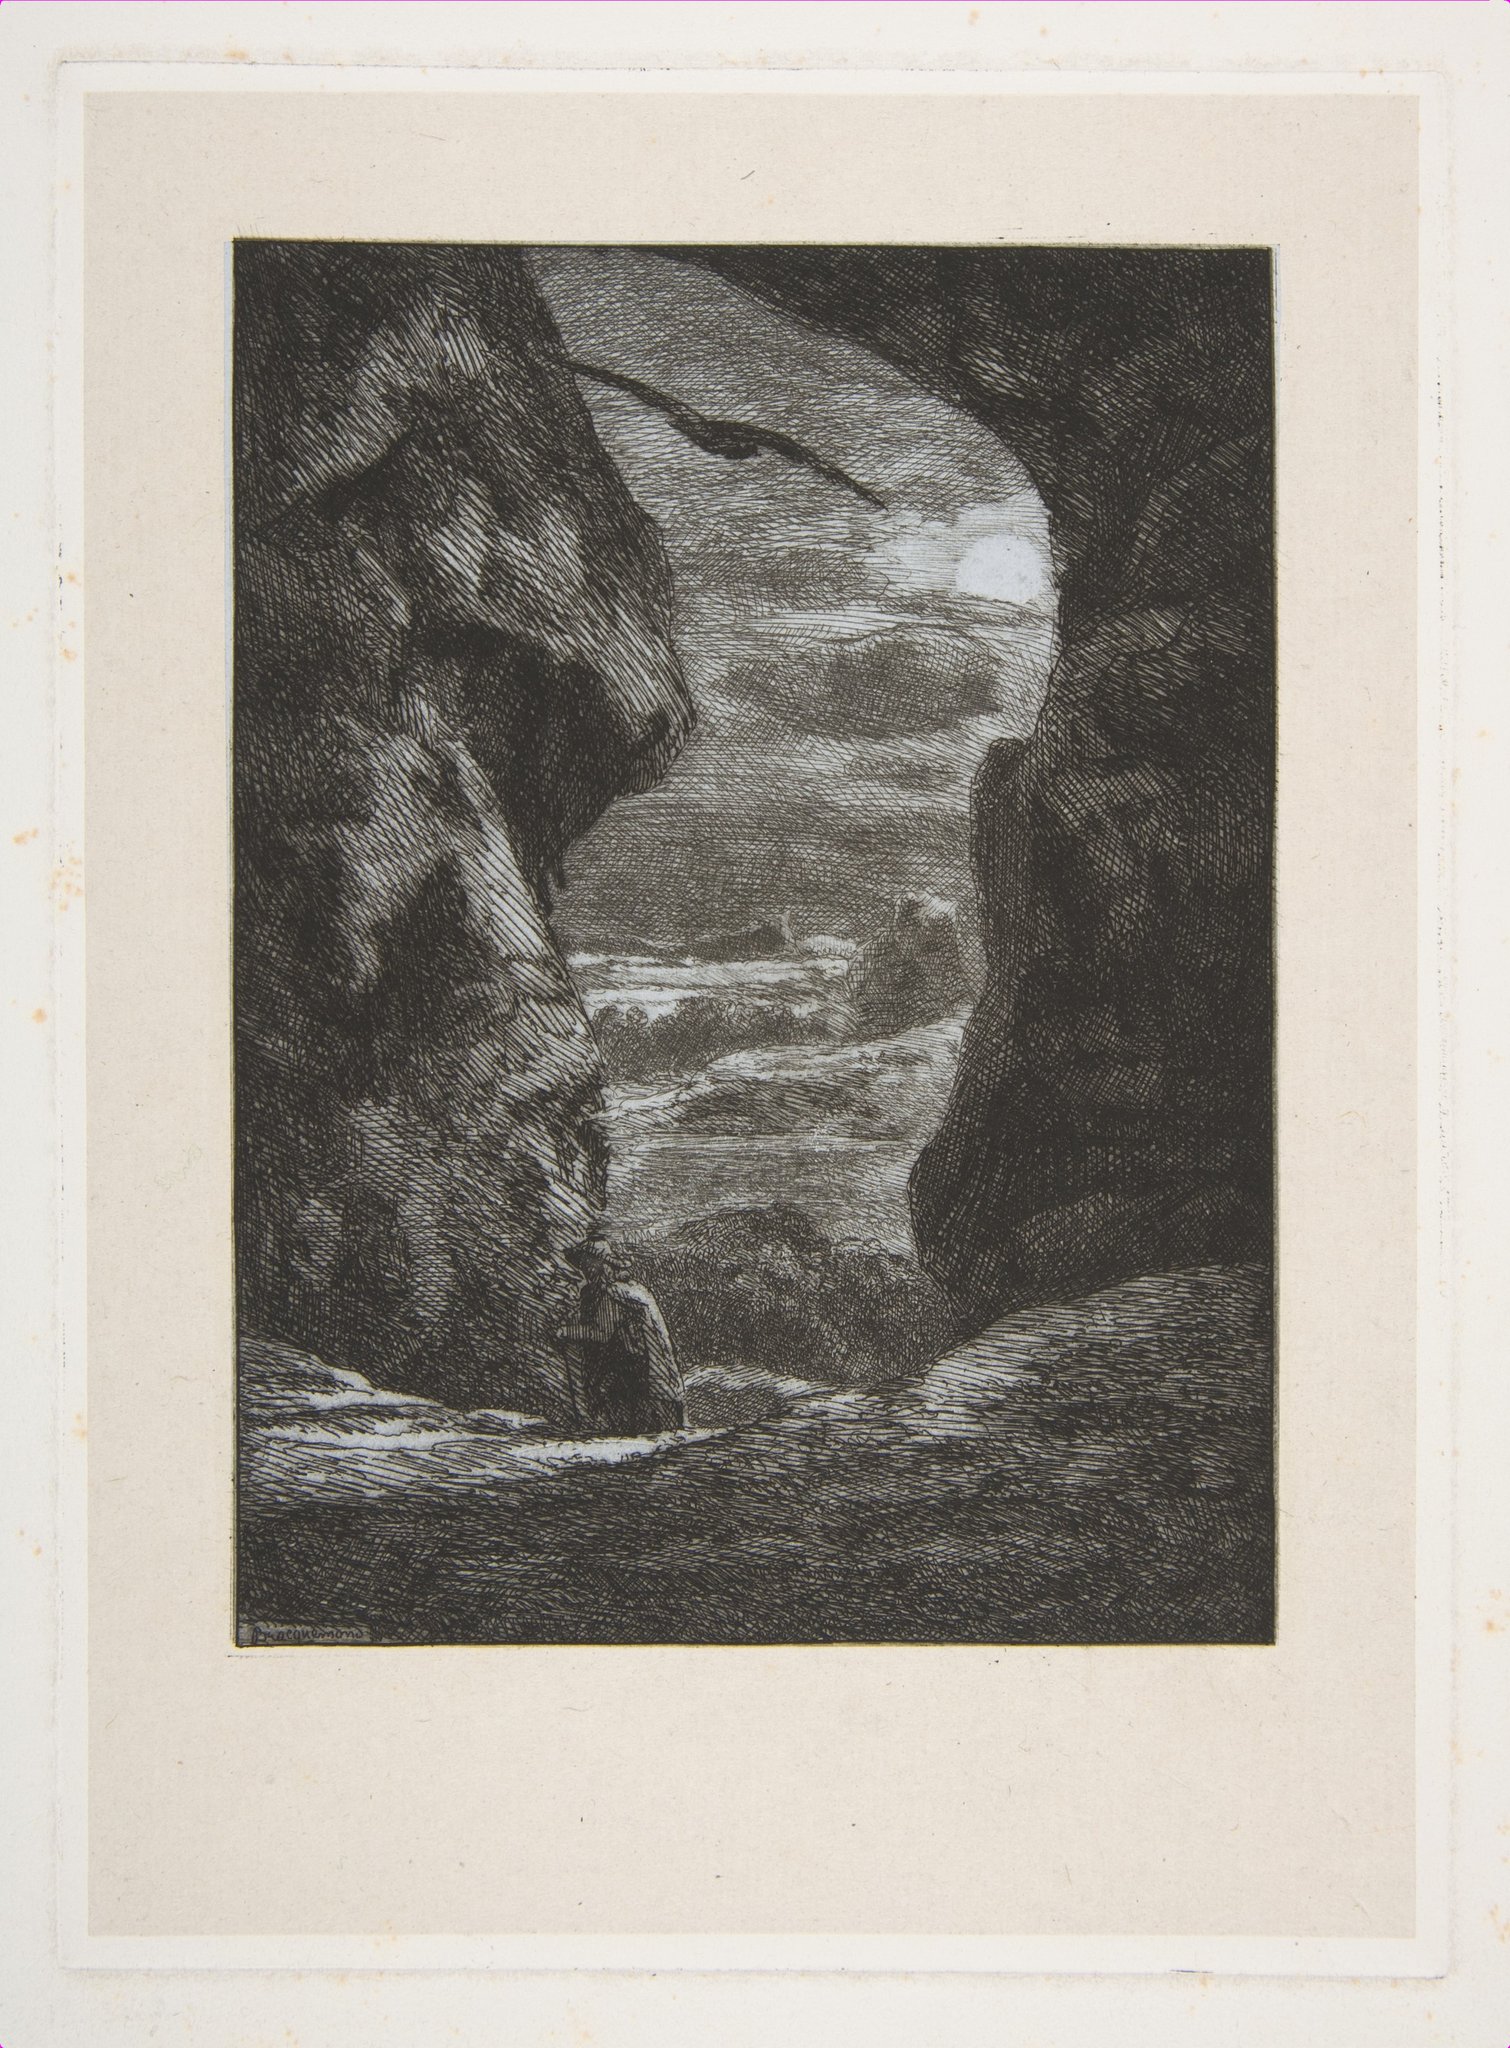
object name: print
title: Adieu aux Karpatz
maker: félix bracquemond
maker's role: artist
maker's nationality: french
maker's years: 1833-1914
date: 1857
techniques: printmaking, etching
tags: eagles,mountains